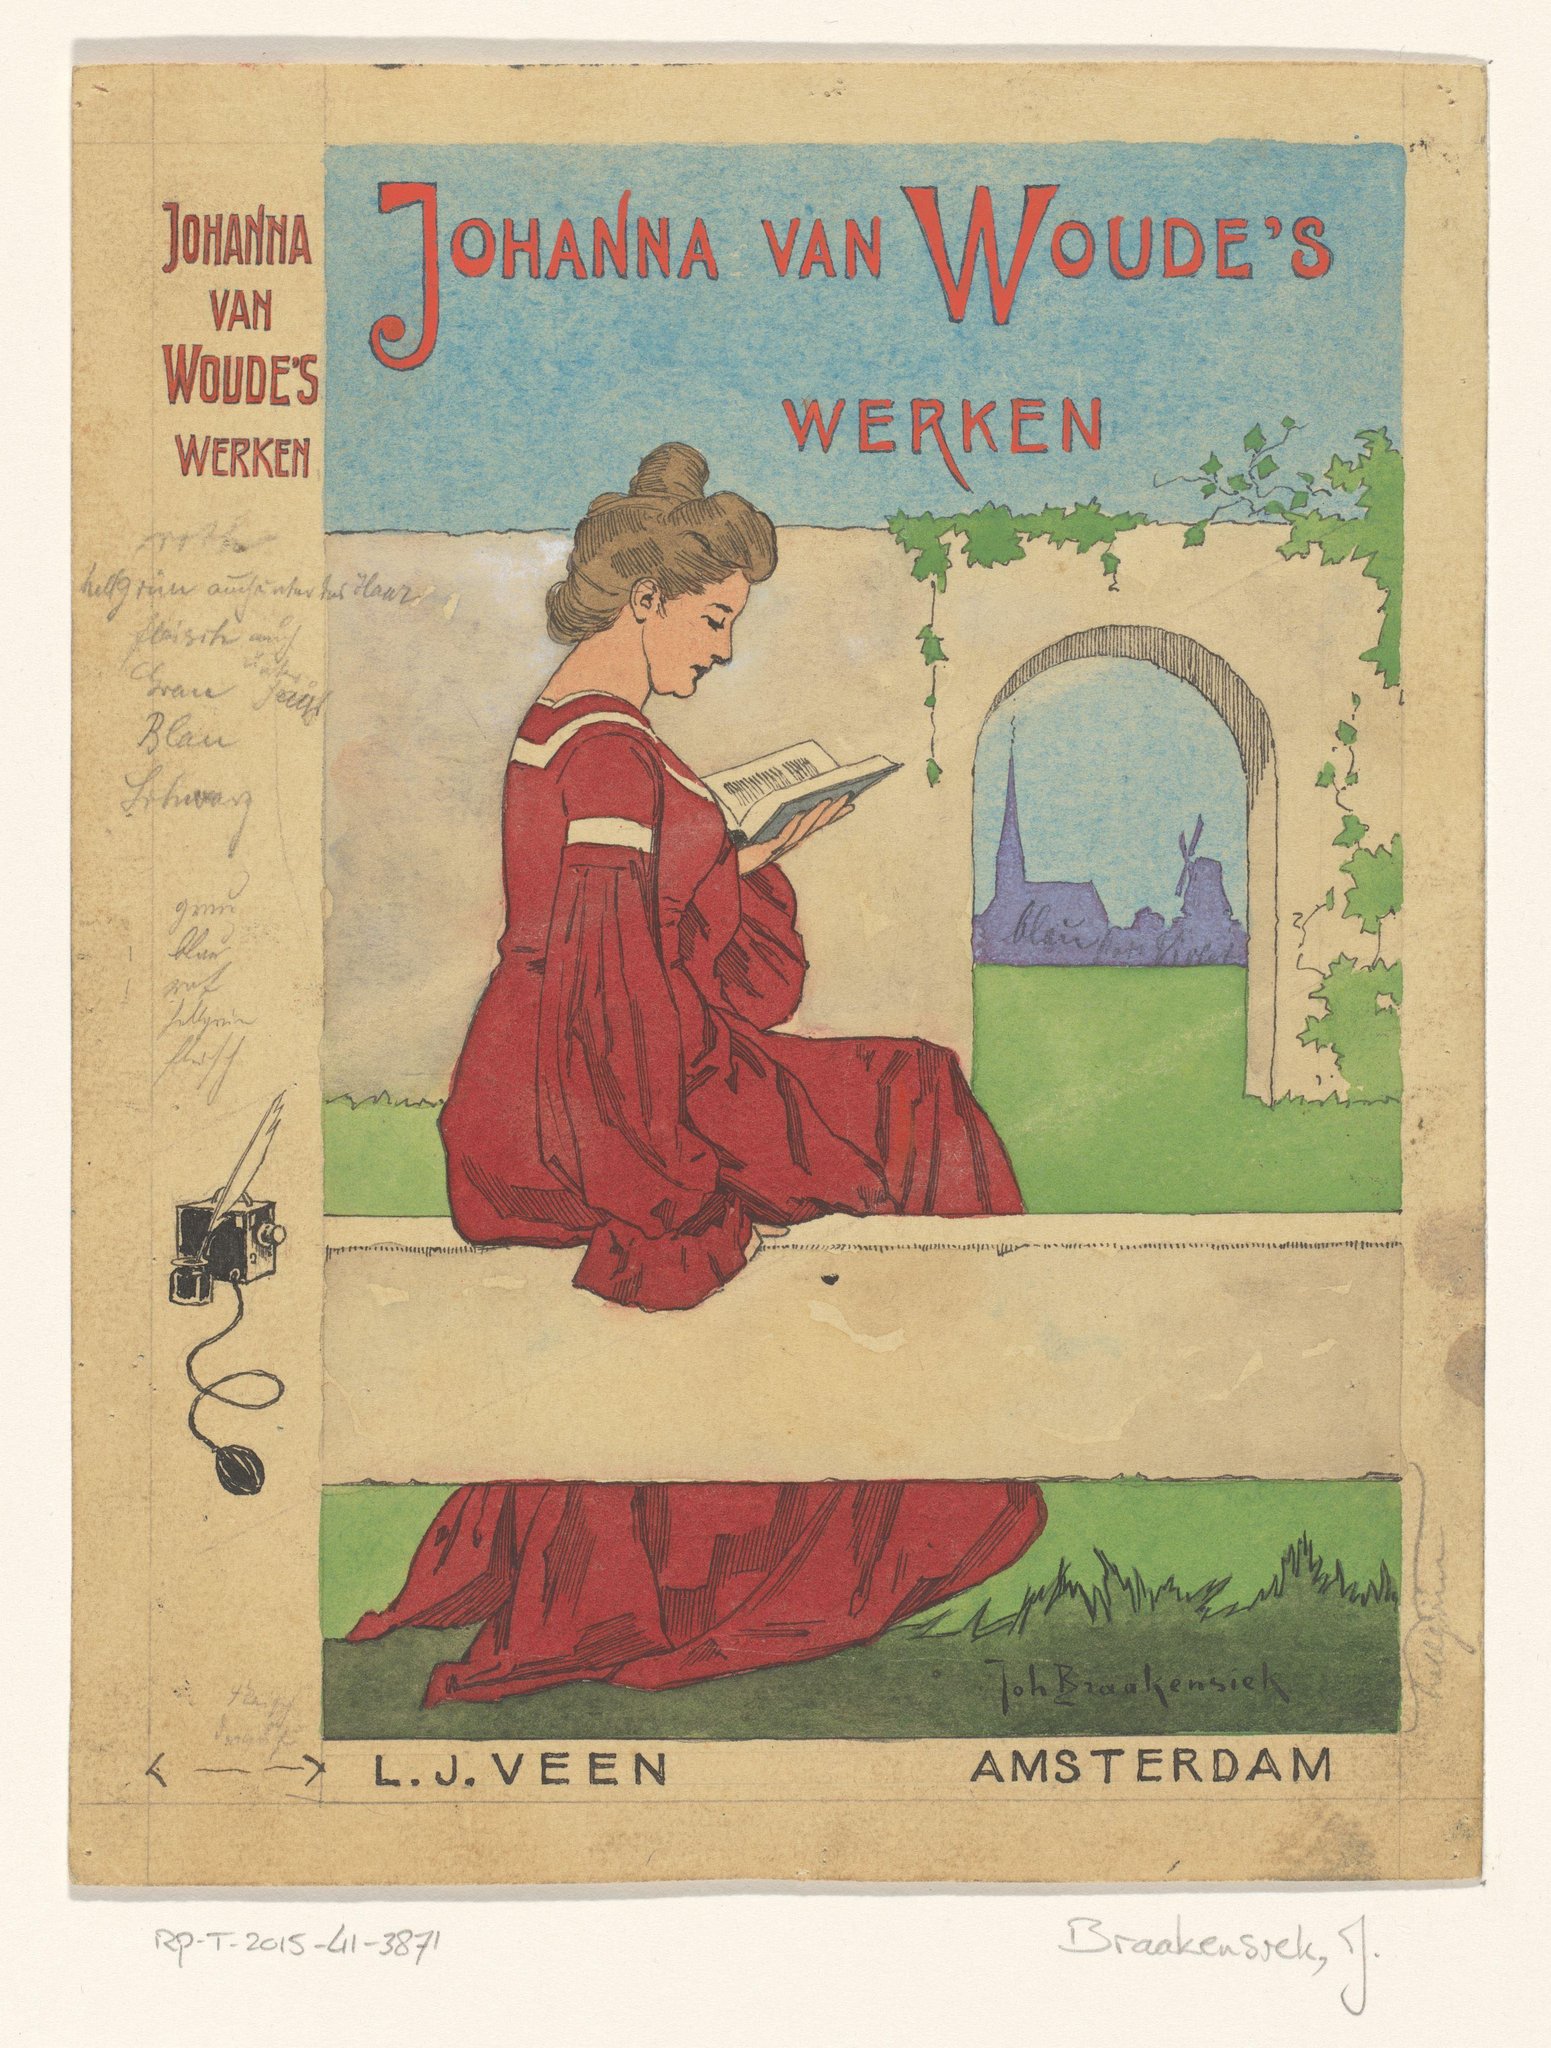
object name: study for binding design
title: Bandontwerp voor de serie: Johanna van Woude's Werken, 1905-1908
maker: johan braakensiek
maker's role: draughtsman, print maker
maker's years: 1858-1940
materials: ink, paper, pencil, watercolor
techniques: brush, pen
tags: prospect of village, silhouette of village, bench, reading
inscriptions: collector's mark: Lugt 2228a, :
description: Een vrouw in een lange jurk zit buiten op een bank een boek te lezen. In de achtergrond een stenen poort, waardoor het silhouet van een dorp met kerktoren en molen te zien is. Op de boekrug een veer in een inktpot en een camera.